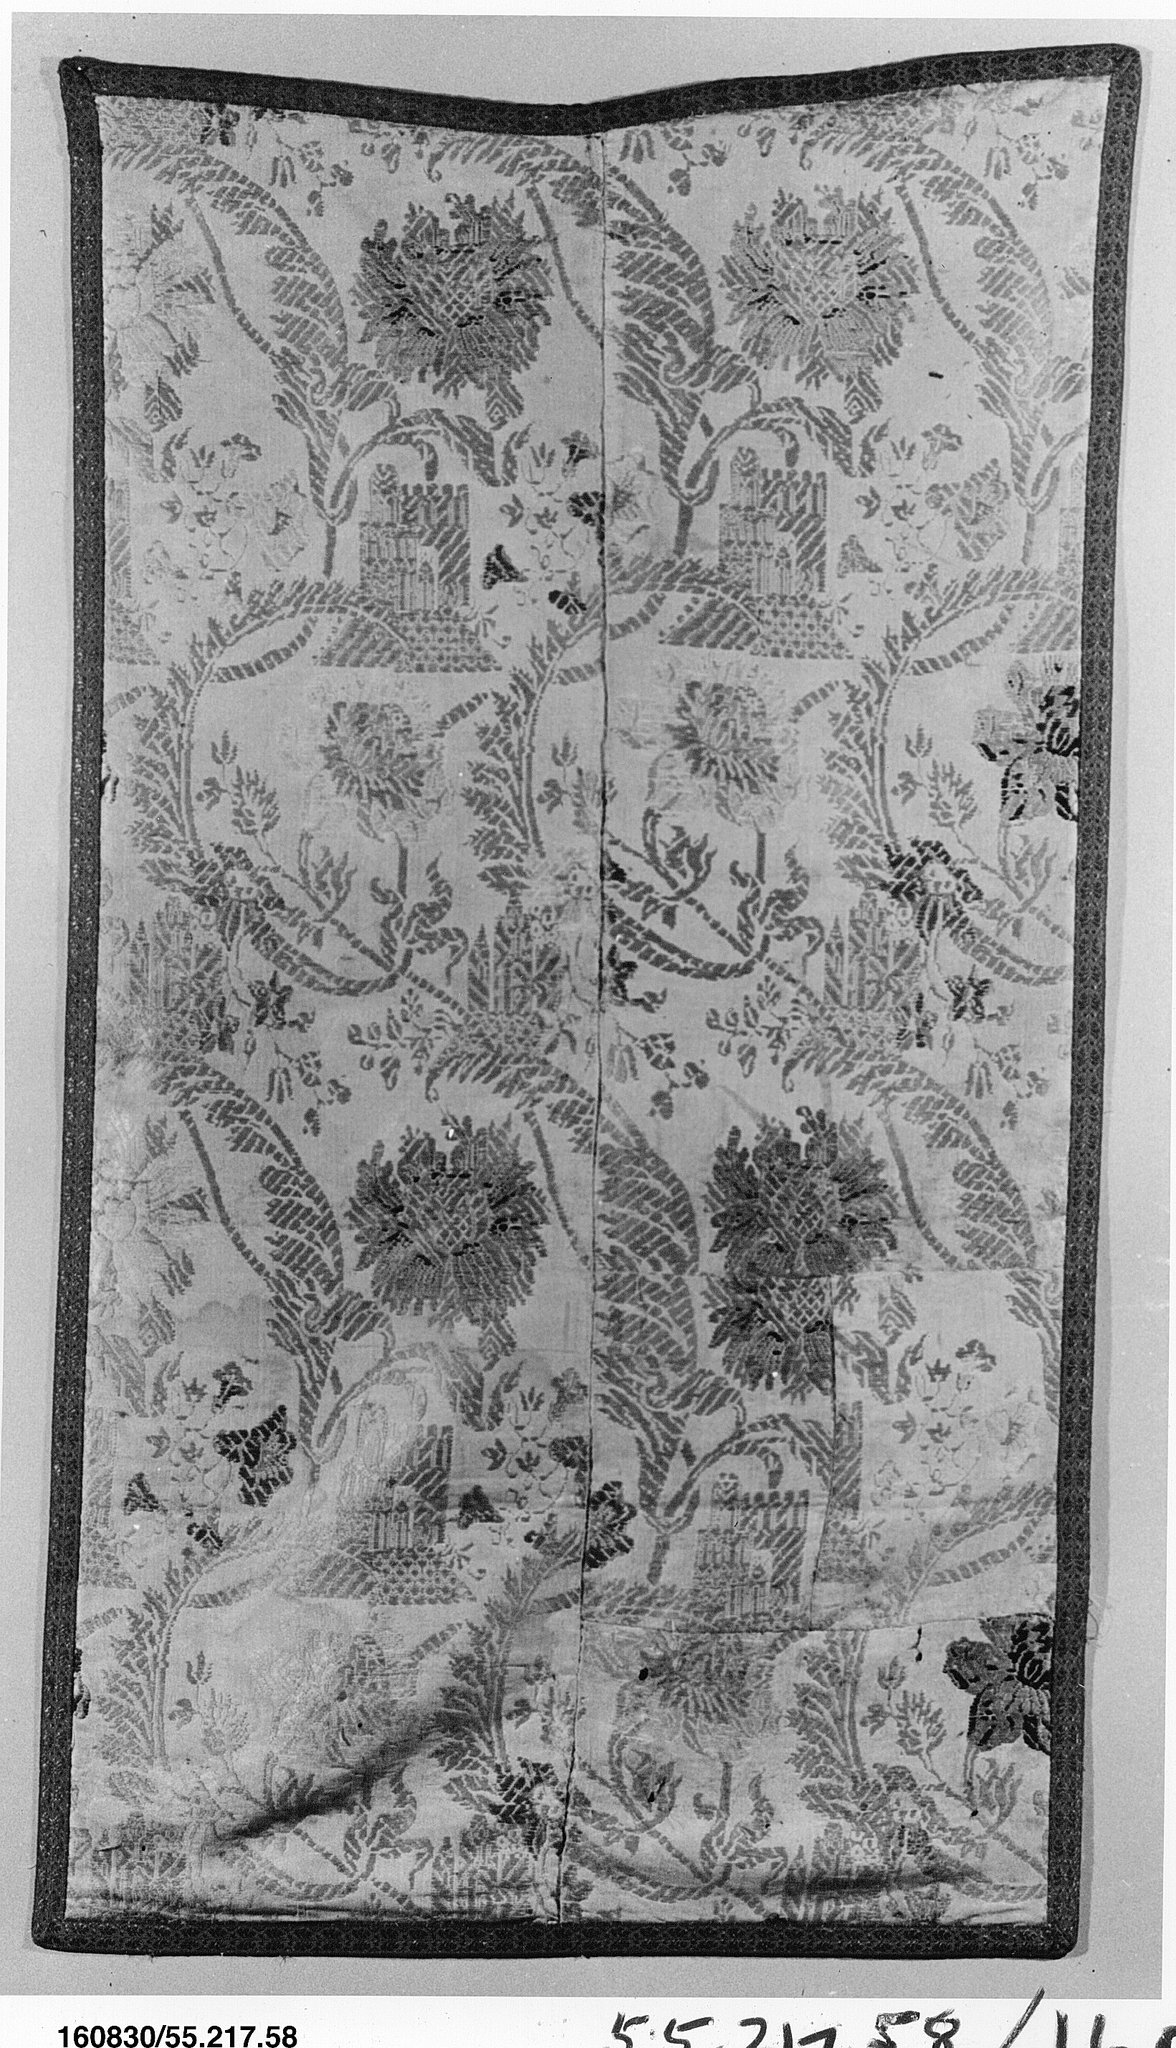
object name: piece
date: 1695-1700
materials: silk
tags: houses,flowers,leaves